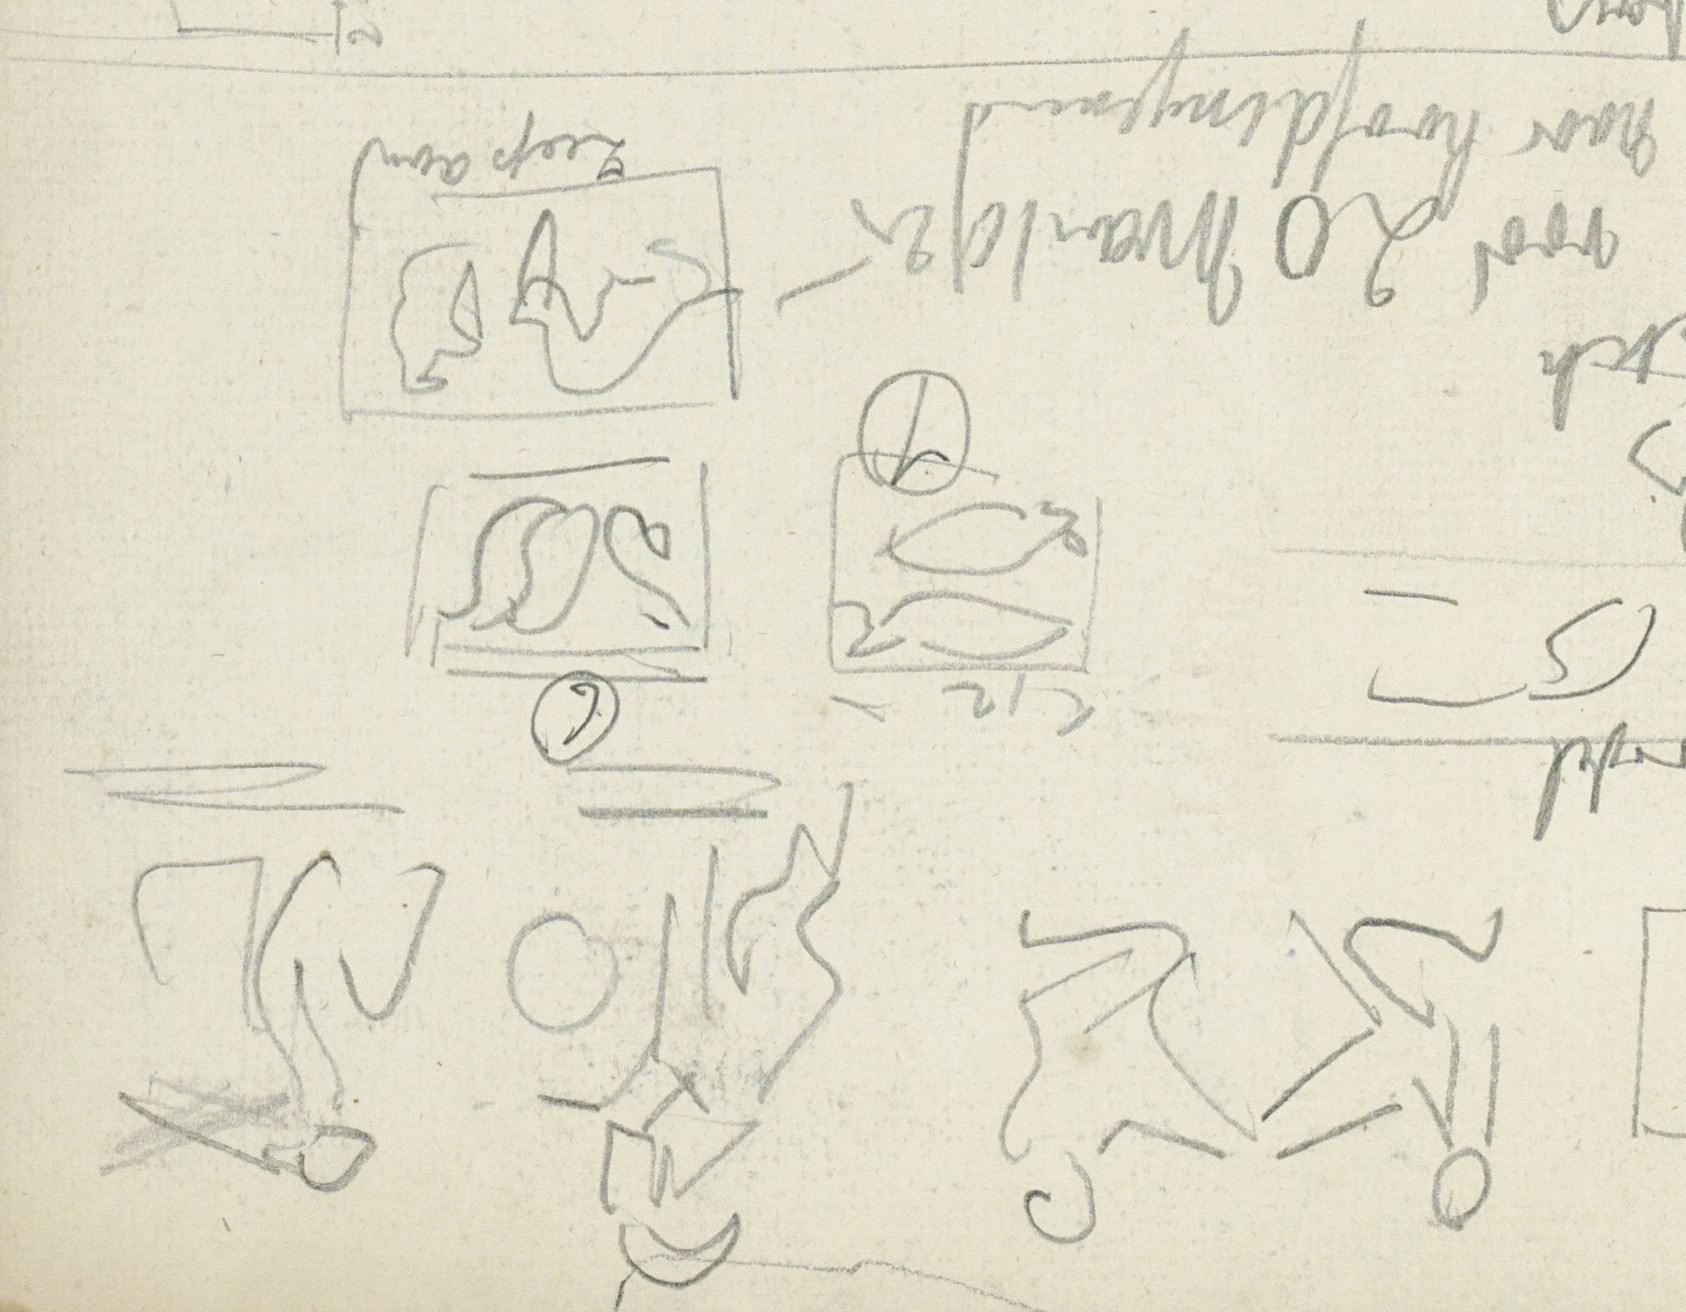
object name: sketchbook leaf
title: Ornamenten met figuren en dieren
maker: carel adolph lion cachet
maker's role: draughtsman, print maker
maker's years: 1864-1945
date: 1928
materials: paper, pencil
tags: ornament derived from animal forms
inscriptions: annotation: ‘gordel/ eet[...]/ voor 20 man 1925/ naar hoofdin[...]/ dikte pilasters/ zeepaard’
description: Onder andere ornamenten met gordeldieren en zeepaardjes. Blad 24 verso uit een schetsboek met 24 bladen.